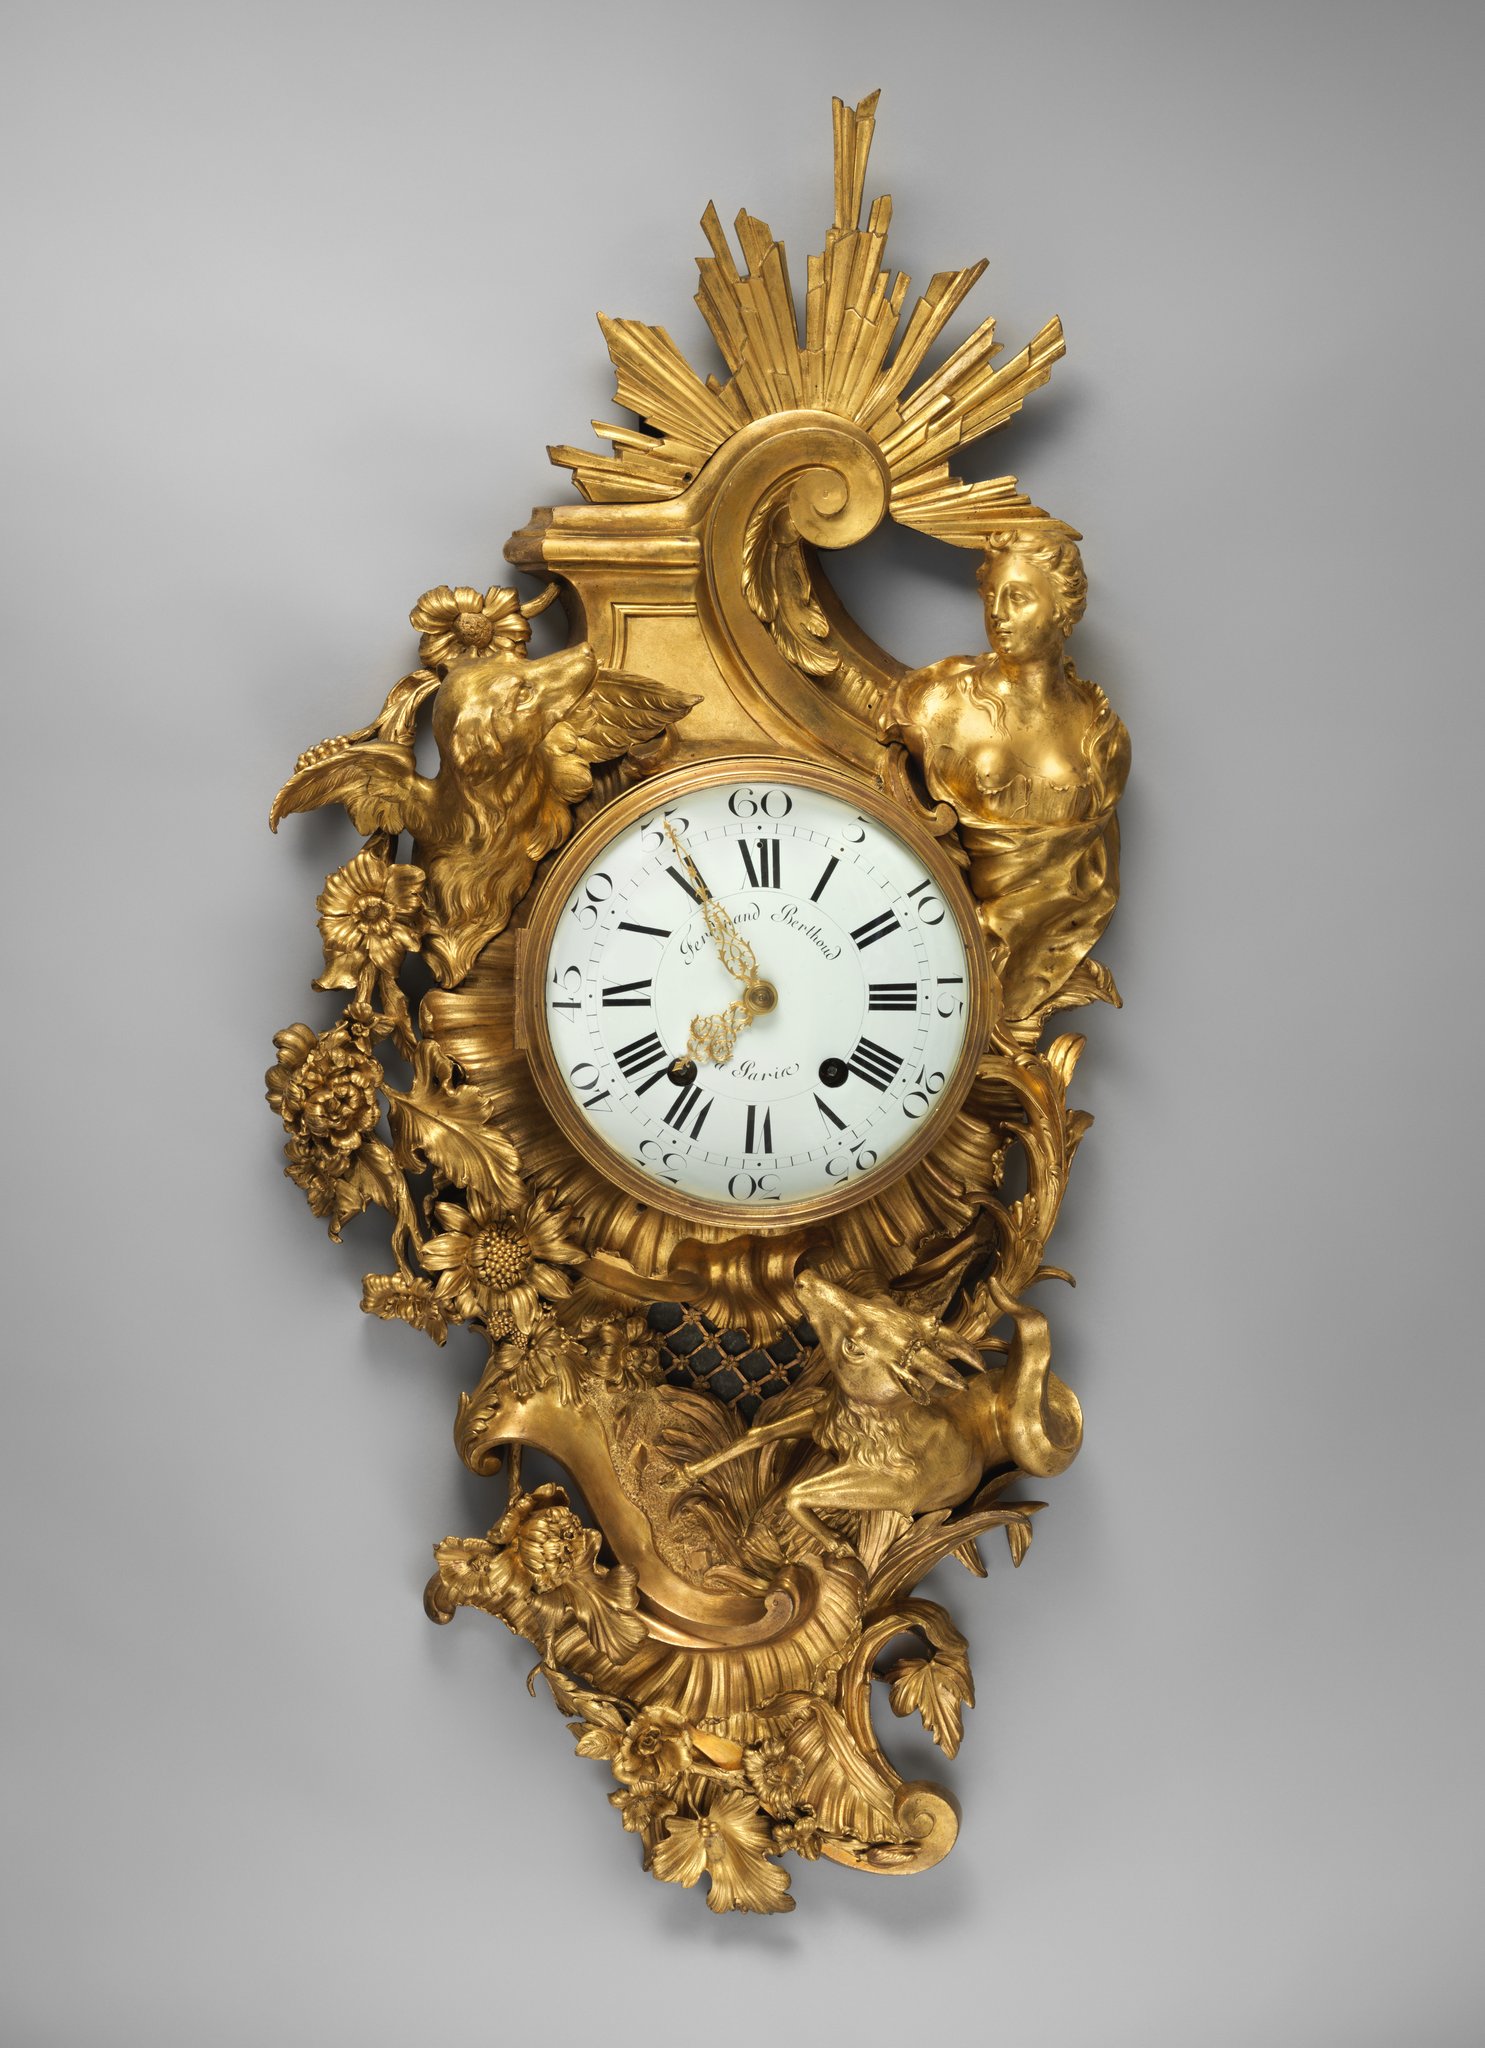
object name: wall clock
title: Wall clock (cartel) with movement of later date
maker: jacques caffieri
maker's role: maker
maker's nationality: french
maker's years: 1678-1755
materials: gilt bronze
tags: women,dogs